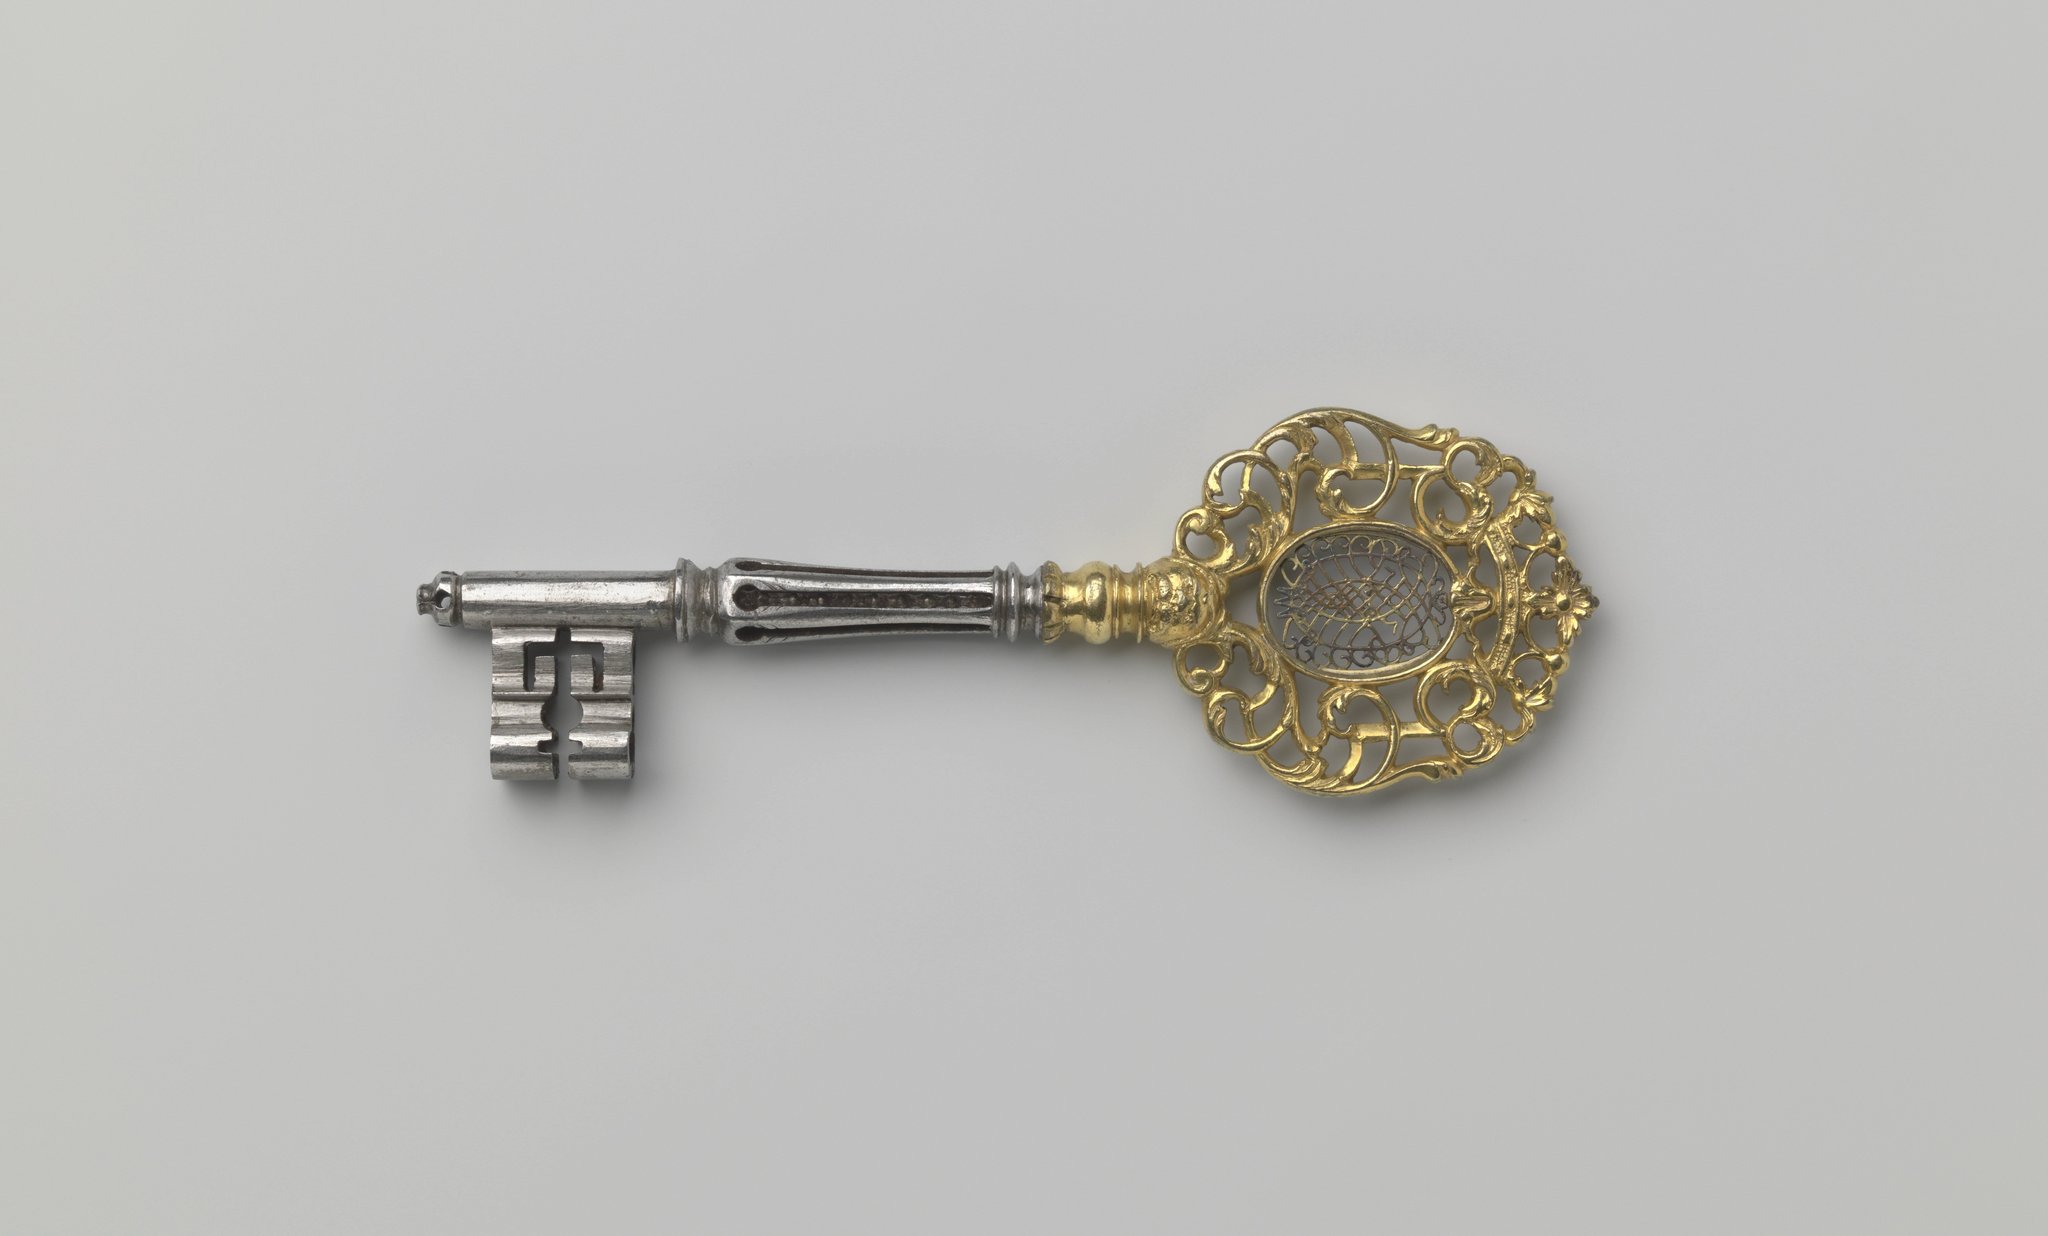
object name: key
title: Sleutel met gekroond monogram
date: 1675-1700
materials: iron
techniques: gilding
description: Fraai bewerkte sleutel van ijzer, het bovenstuk geheel verguld. Met kroon bedekte initialen, tussen ornamenten gevat.